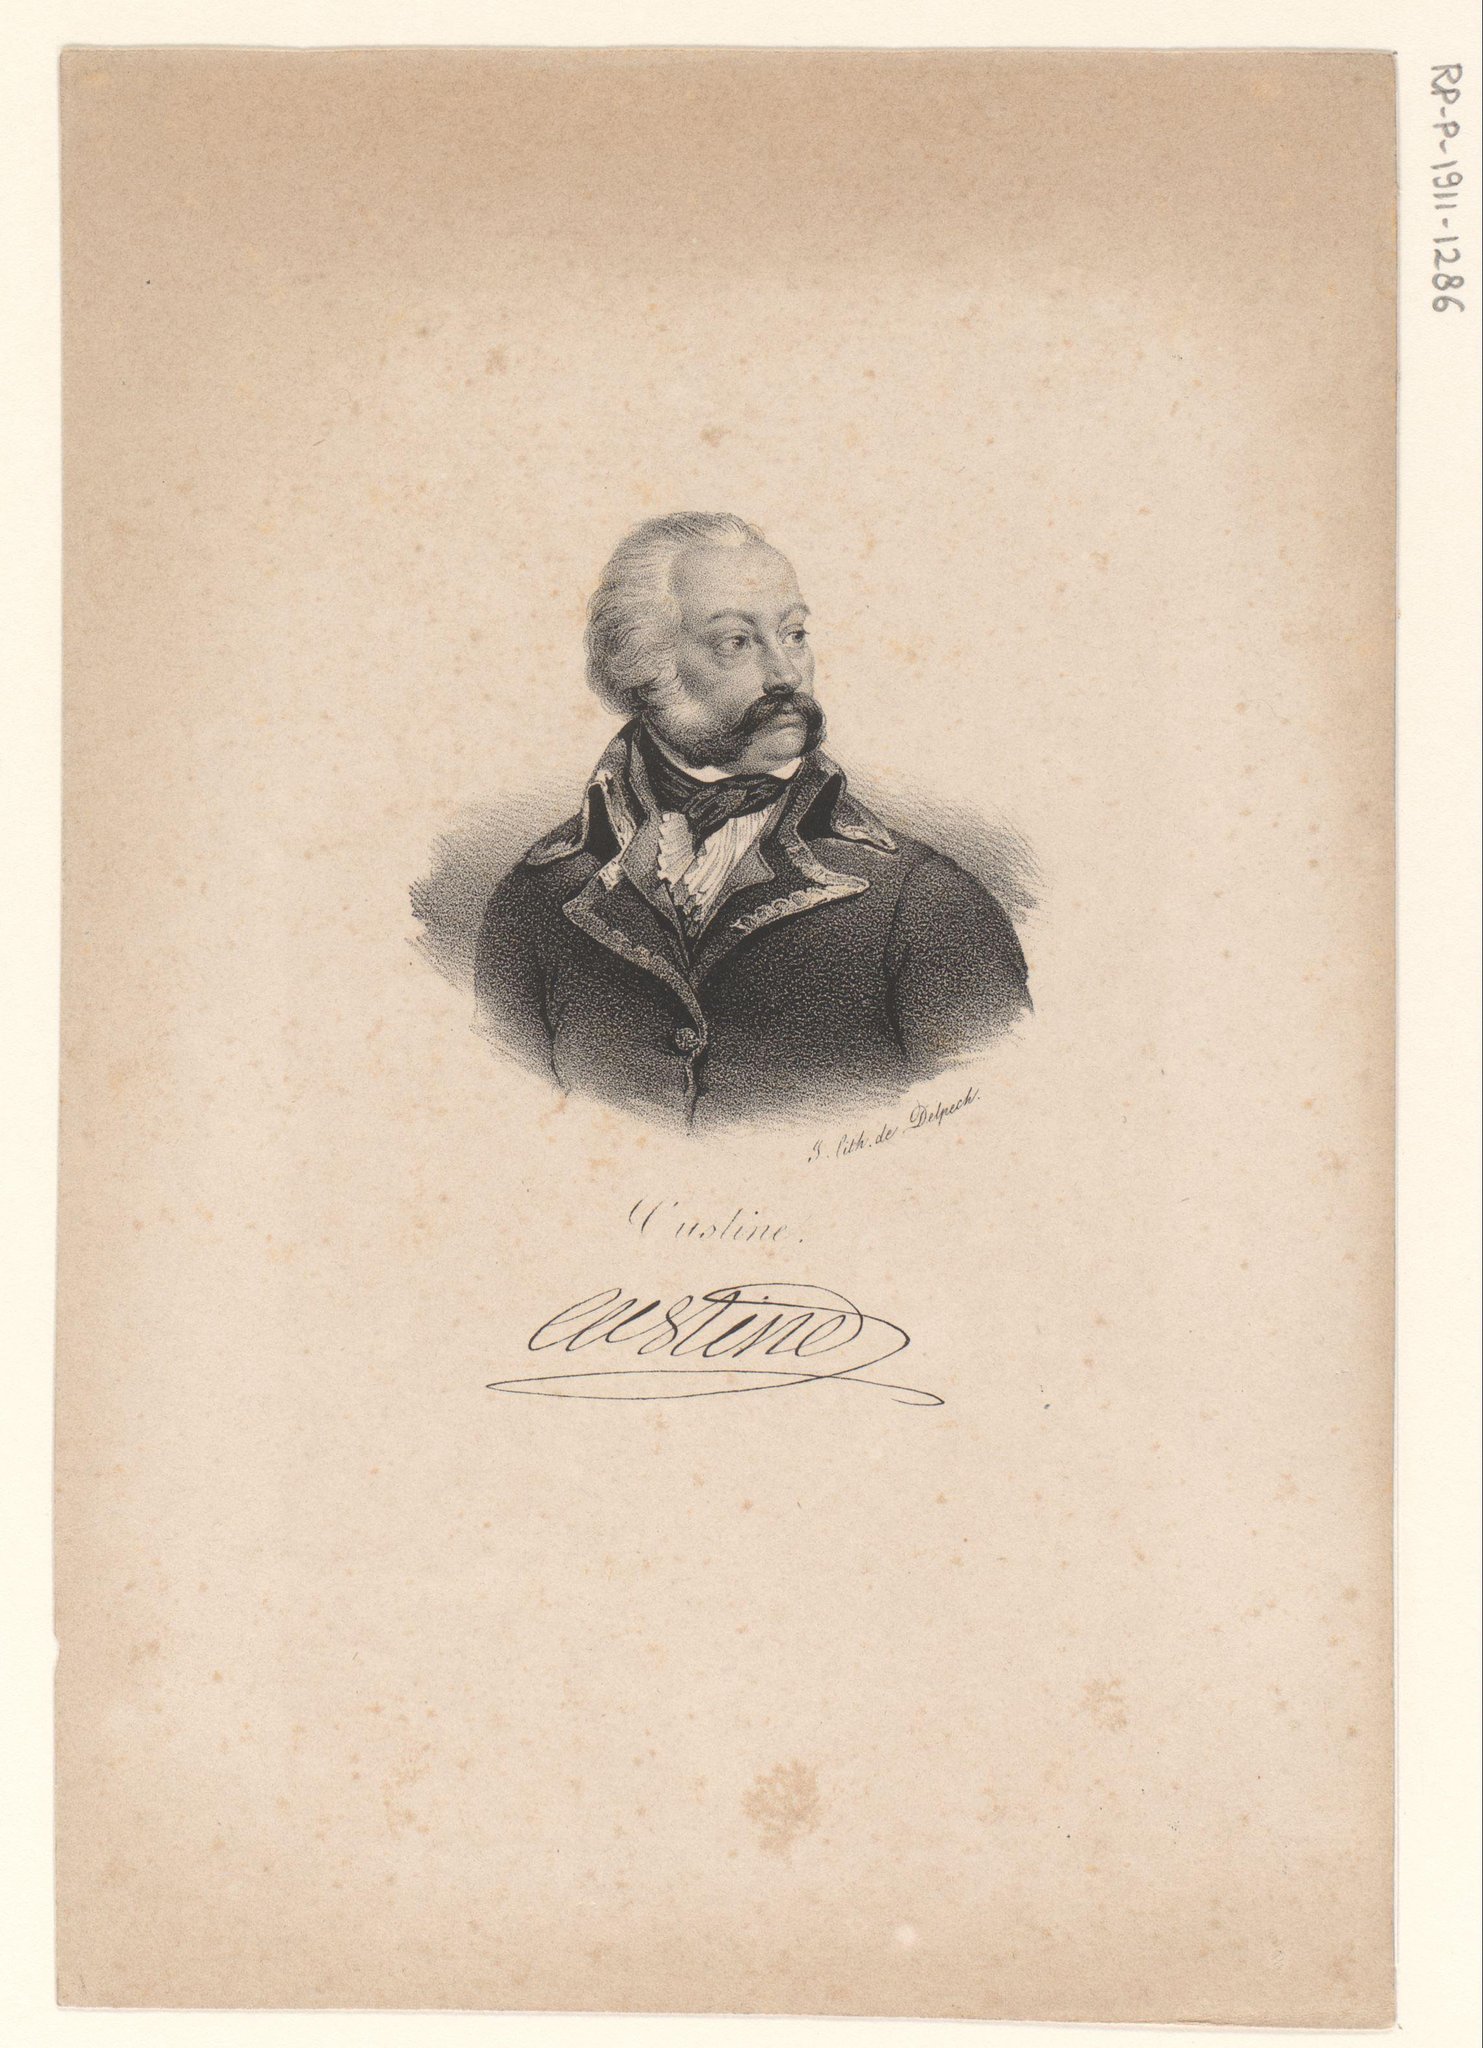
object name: print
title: Portret van Adam-Philippe de Custine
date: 1818-1842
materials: paper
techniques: lithograph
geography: paris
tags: paris, historical persons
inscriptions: collector's mark: Lugt 2228a